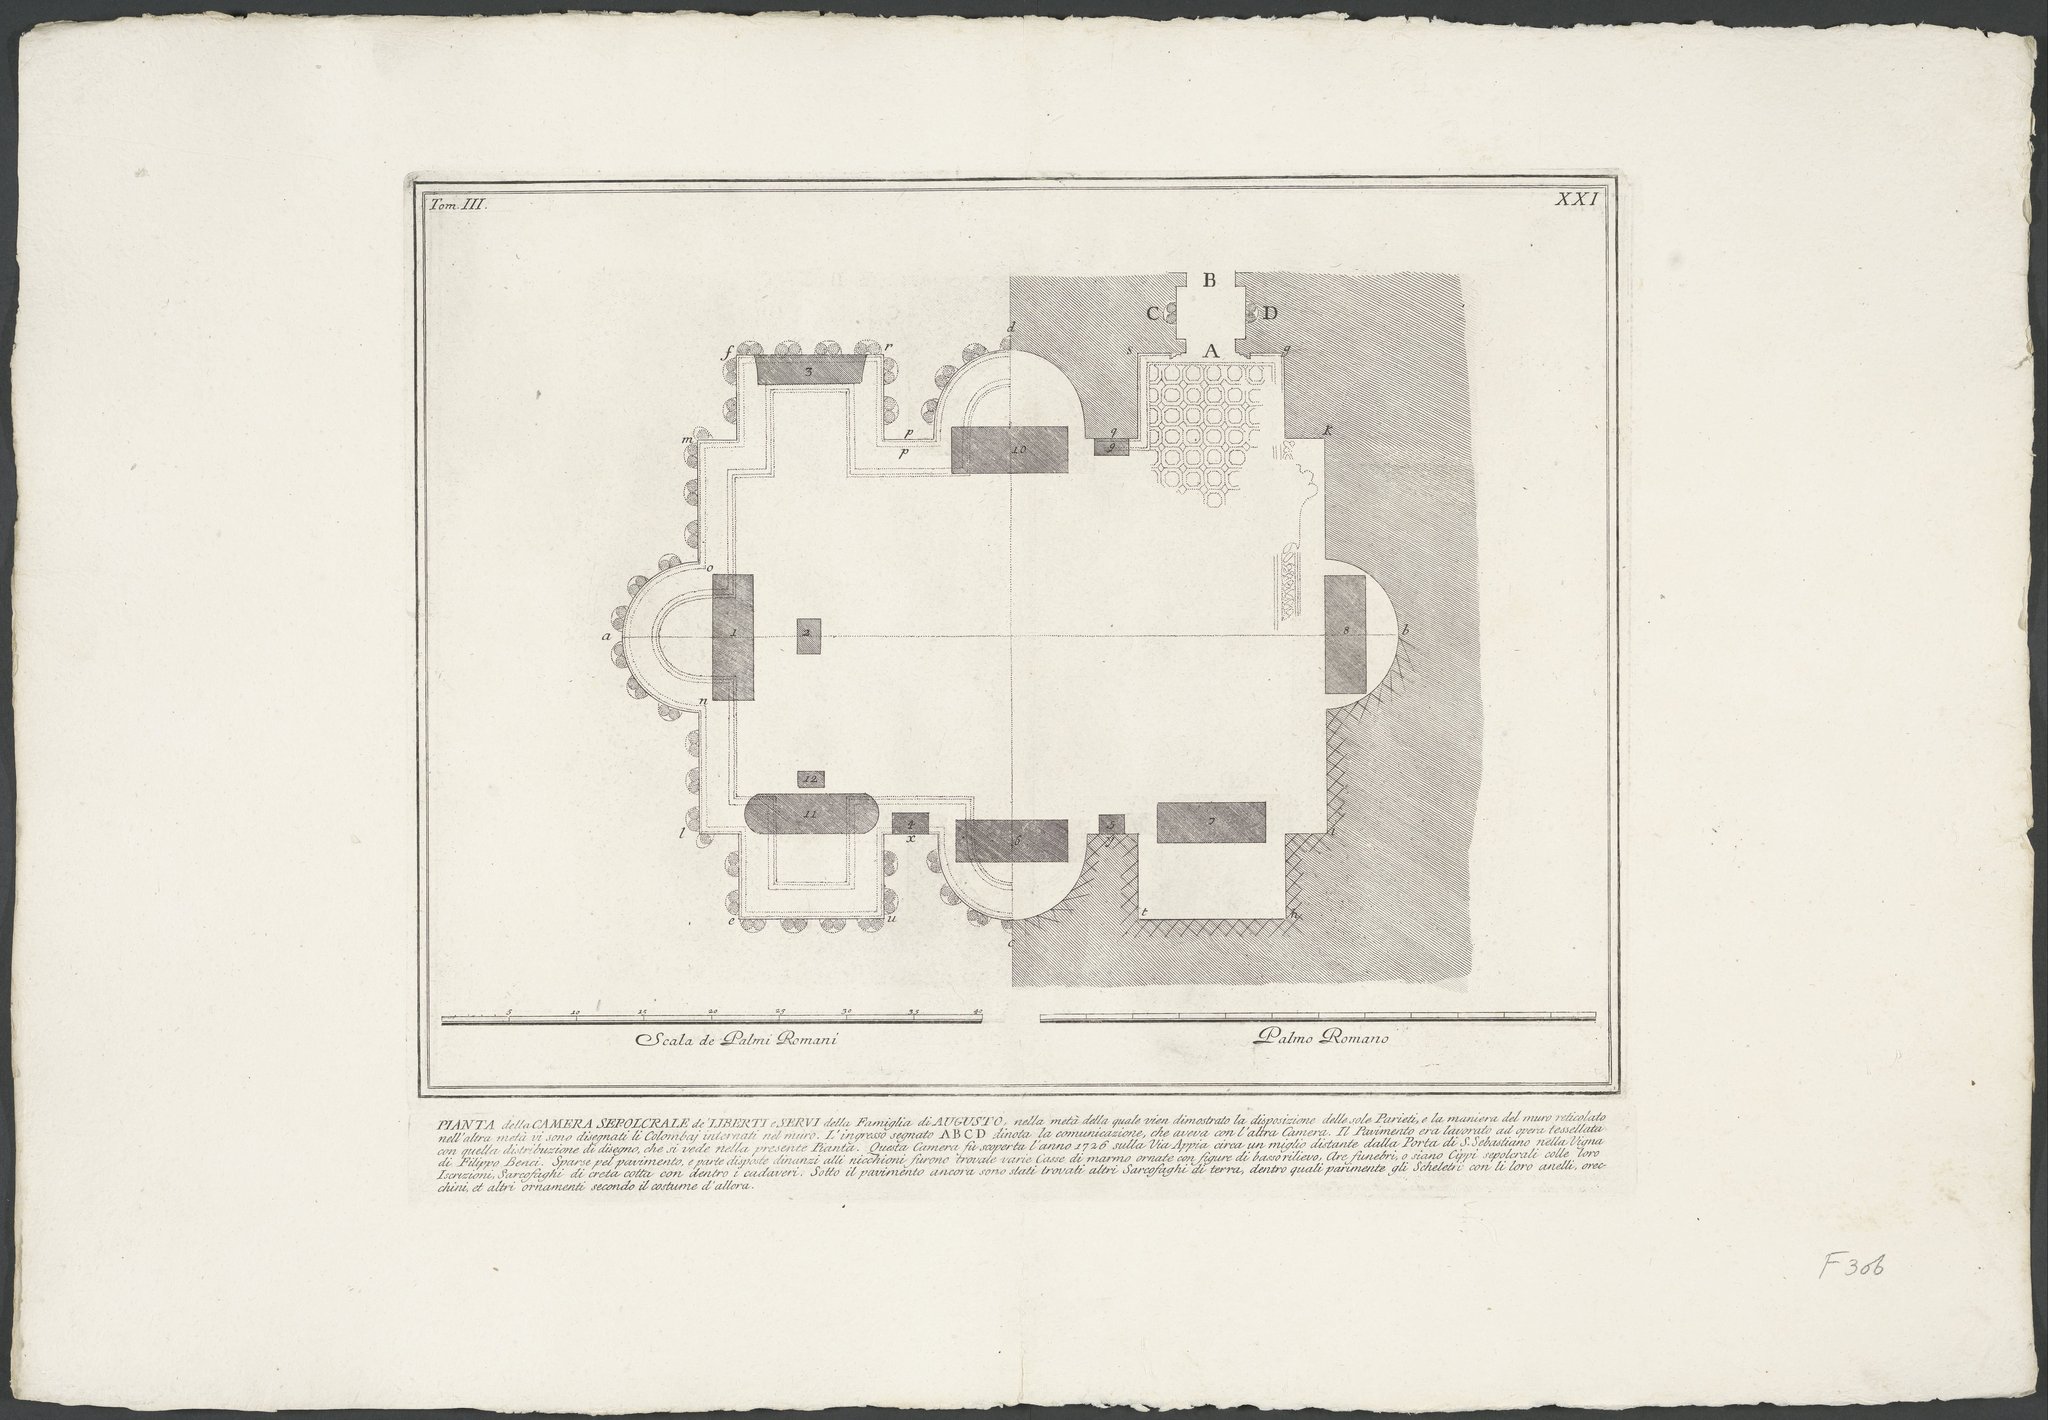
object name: print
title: Plattegrond van graftombe van de vrijgelatenen en slaven van de familie van Augustus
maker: Anonymous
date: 1756-1757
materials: paper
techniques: etching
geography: italy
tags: grave, tomb, slavery; serfs and enslaved persons, freedom ~ slavery, plan ~ architecture, italy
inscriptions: collector's mark: Lugt 2228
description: Deze prent maakt deel uit van de serie 'Le Antichità Romane'. Piranesi deed meer dan acht jaar voorstudie voor deze 250 platen tellende serie die in vier volumes werd uitgegeven. Hij produceerde de prenten tussen ca. 1756 en 1757. De serie bevat ook prenten door of naar andere prentmakers, onder wie Francesco Bianchini en Girolamo Rossi.